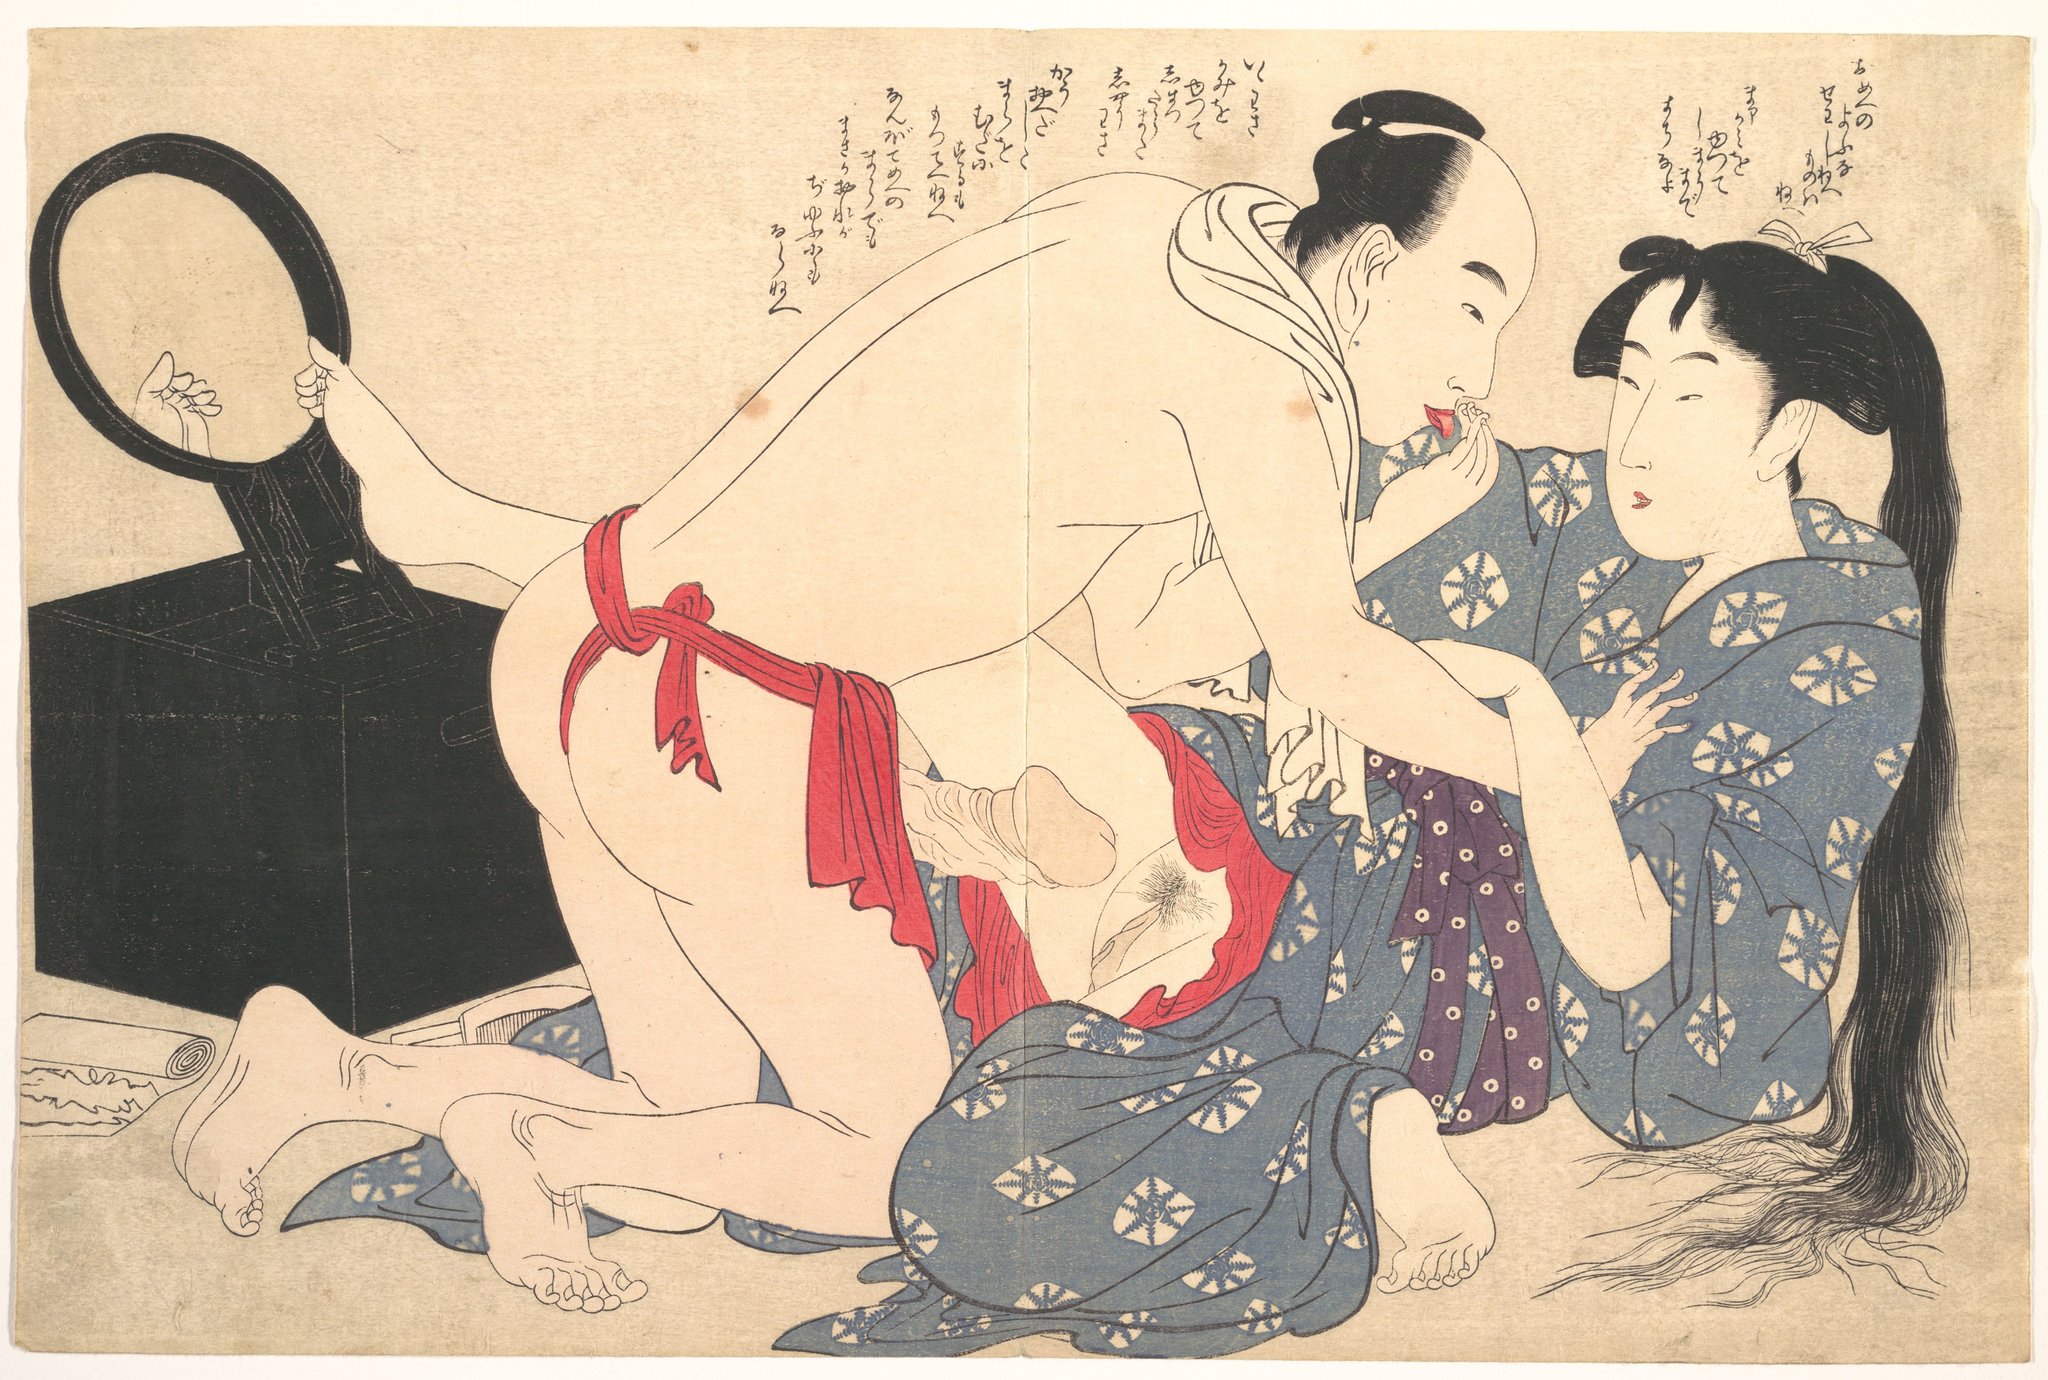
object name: print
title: Erotic Print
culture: japanese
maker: kitagawa utamaro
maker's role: artist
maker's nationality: japanese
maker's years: 1754-1806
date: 1753-1806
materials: ink, paper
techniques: woodblock print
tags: male nudes,women